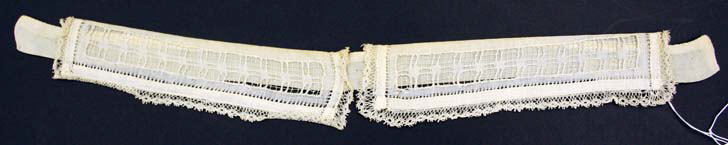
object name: collar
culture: american or european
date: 1700-1945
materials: cotton